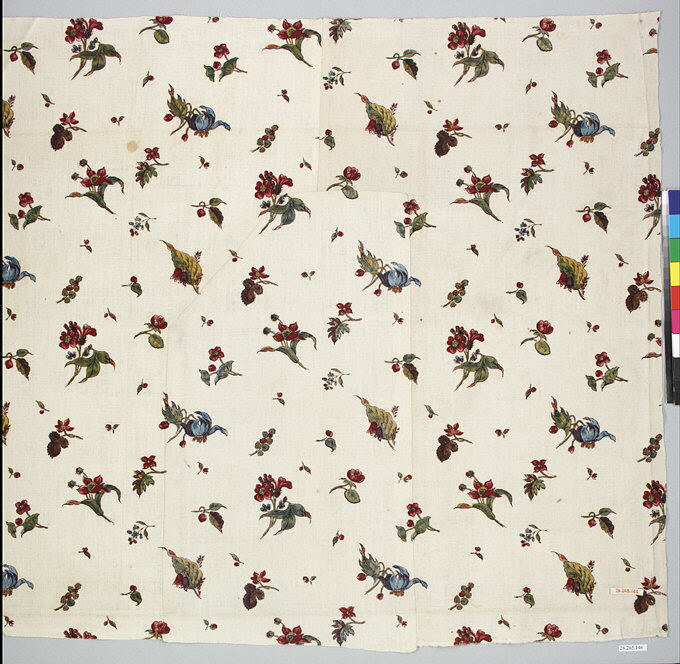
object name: piece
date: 1767-1800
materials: cotton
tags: flowers